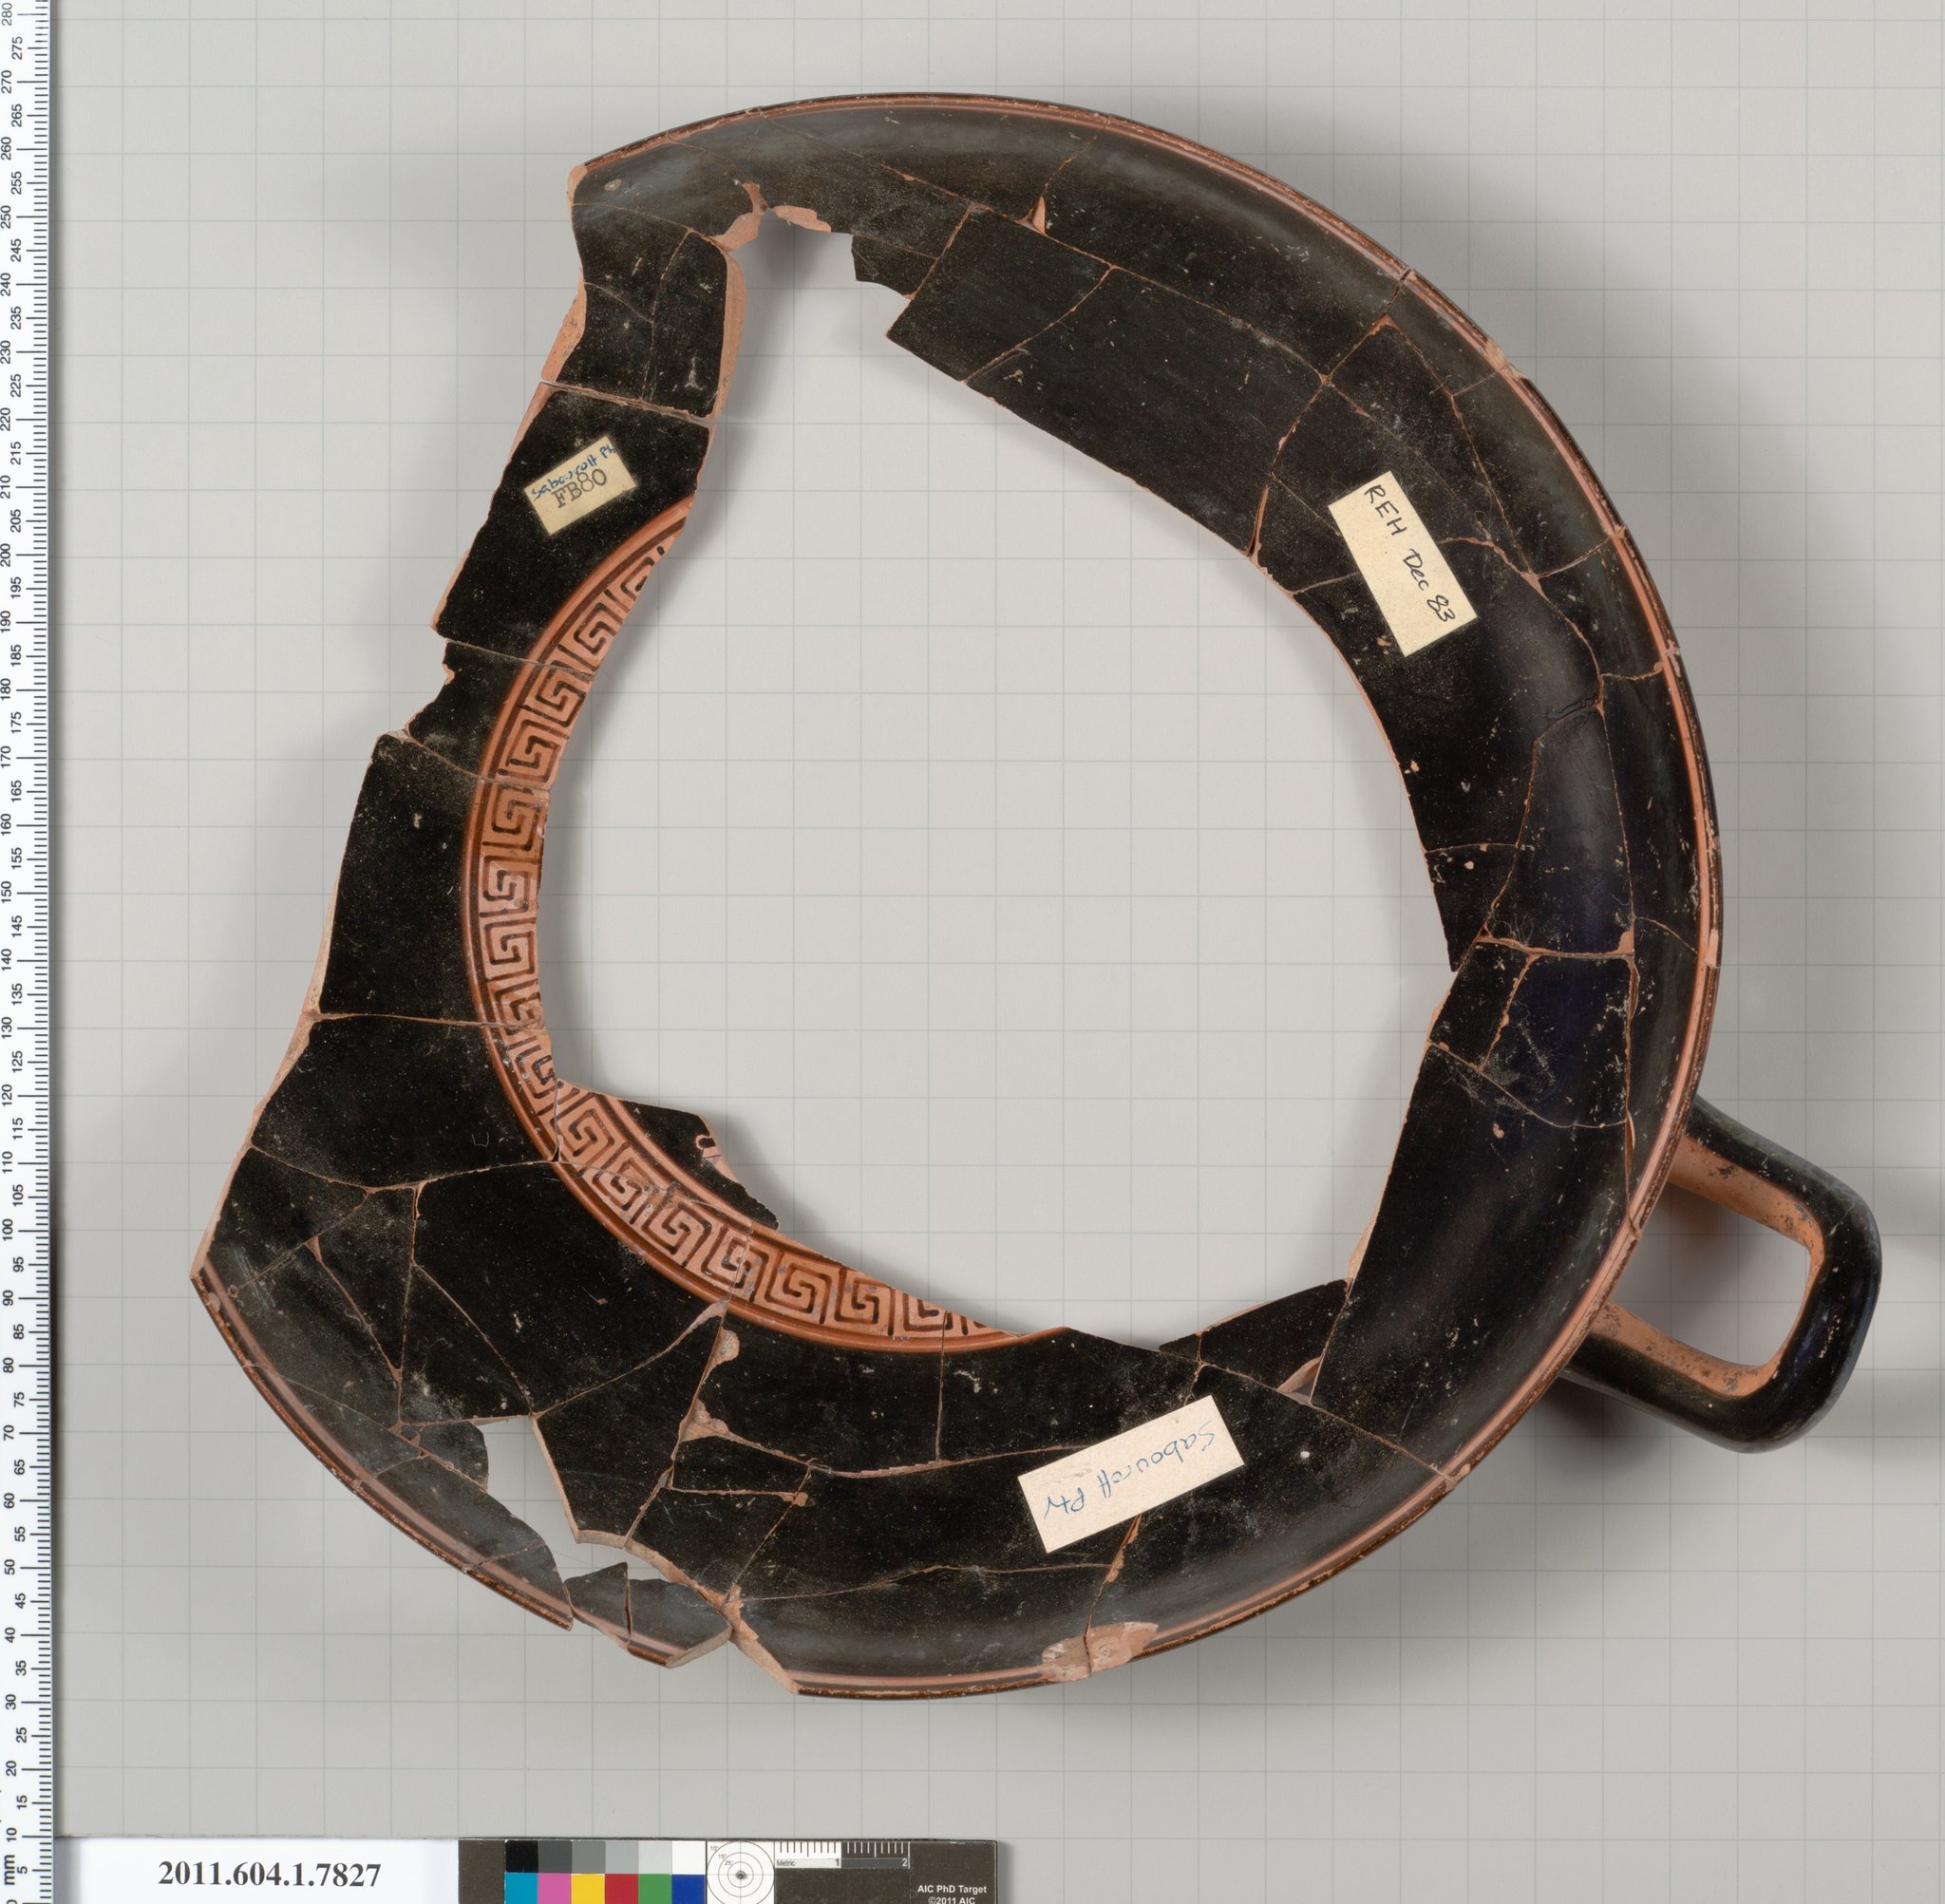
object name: kylix fragment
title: Terracotta fragment of a kylix (drinking cup)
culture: greek, attic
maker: sabouroff painter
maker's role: artist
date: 467-435 BCE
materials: terracotta